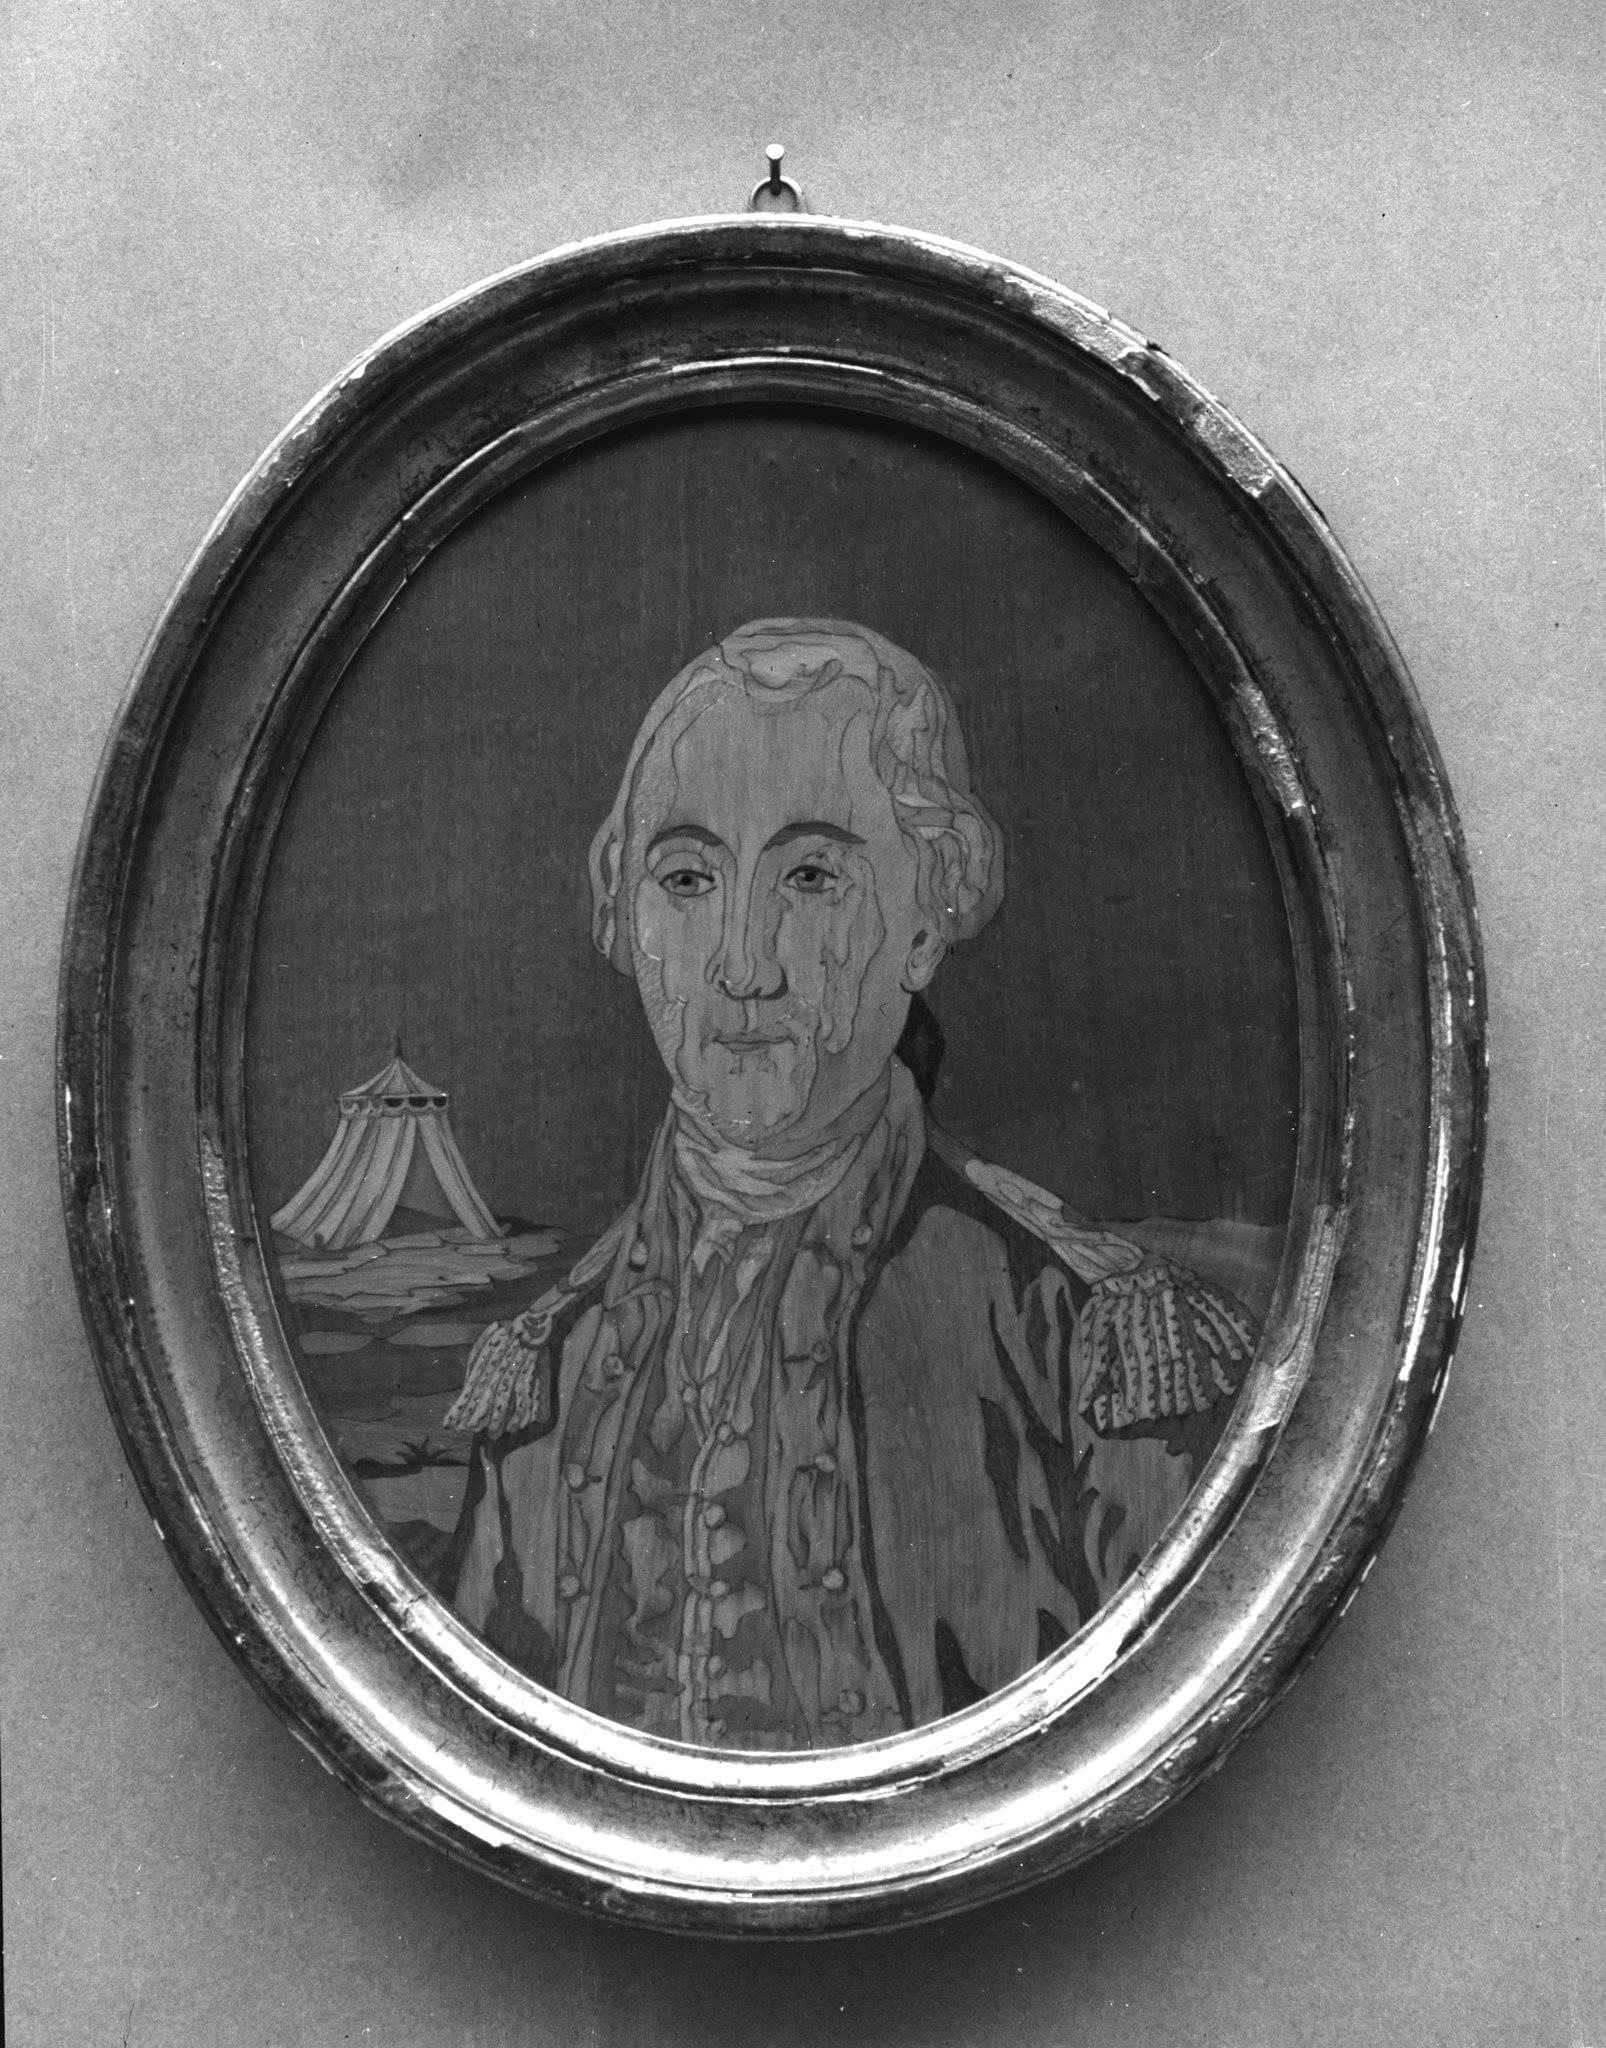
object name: portrait panel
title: Portrait Panel of George Washington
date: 1780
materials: wood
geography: germany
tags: george washington,portraits